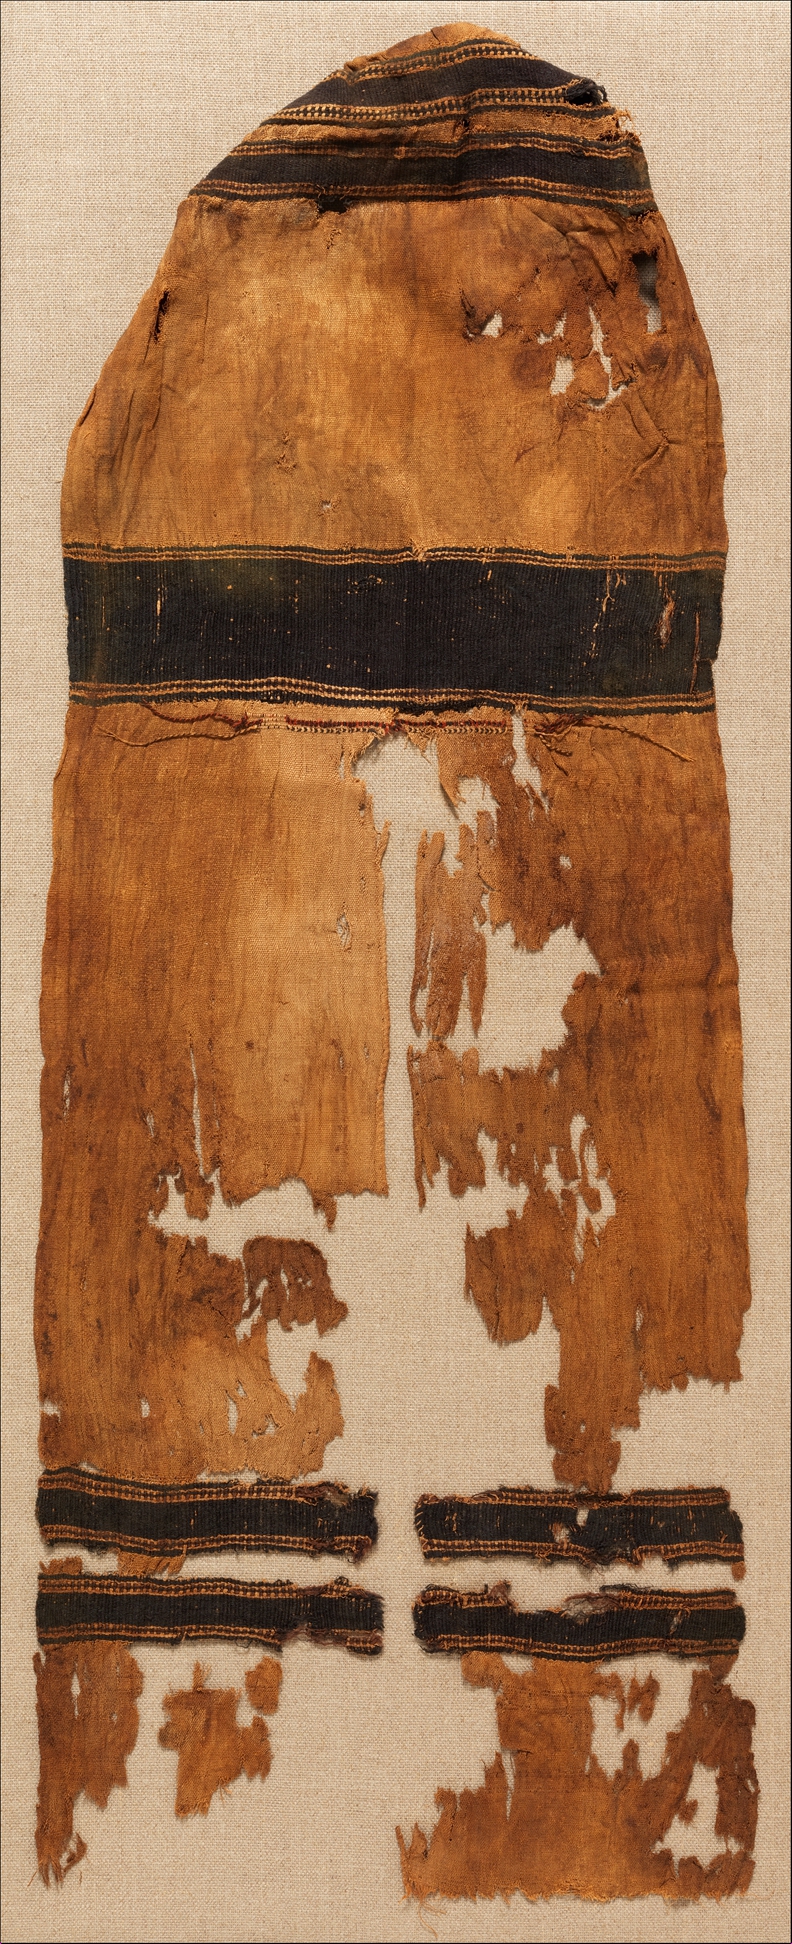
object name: fragment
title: Extended Cap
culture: coptic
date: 301-700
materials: linen, thread, wool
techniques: weave, polychrome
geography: egypt